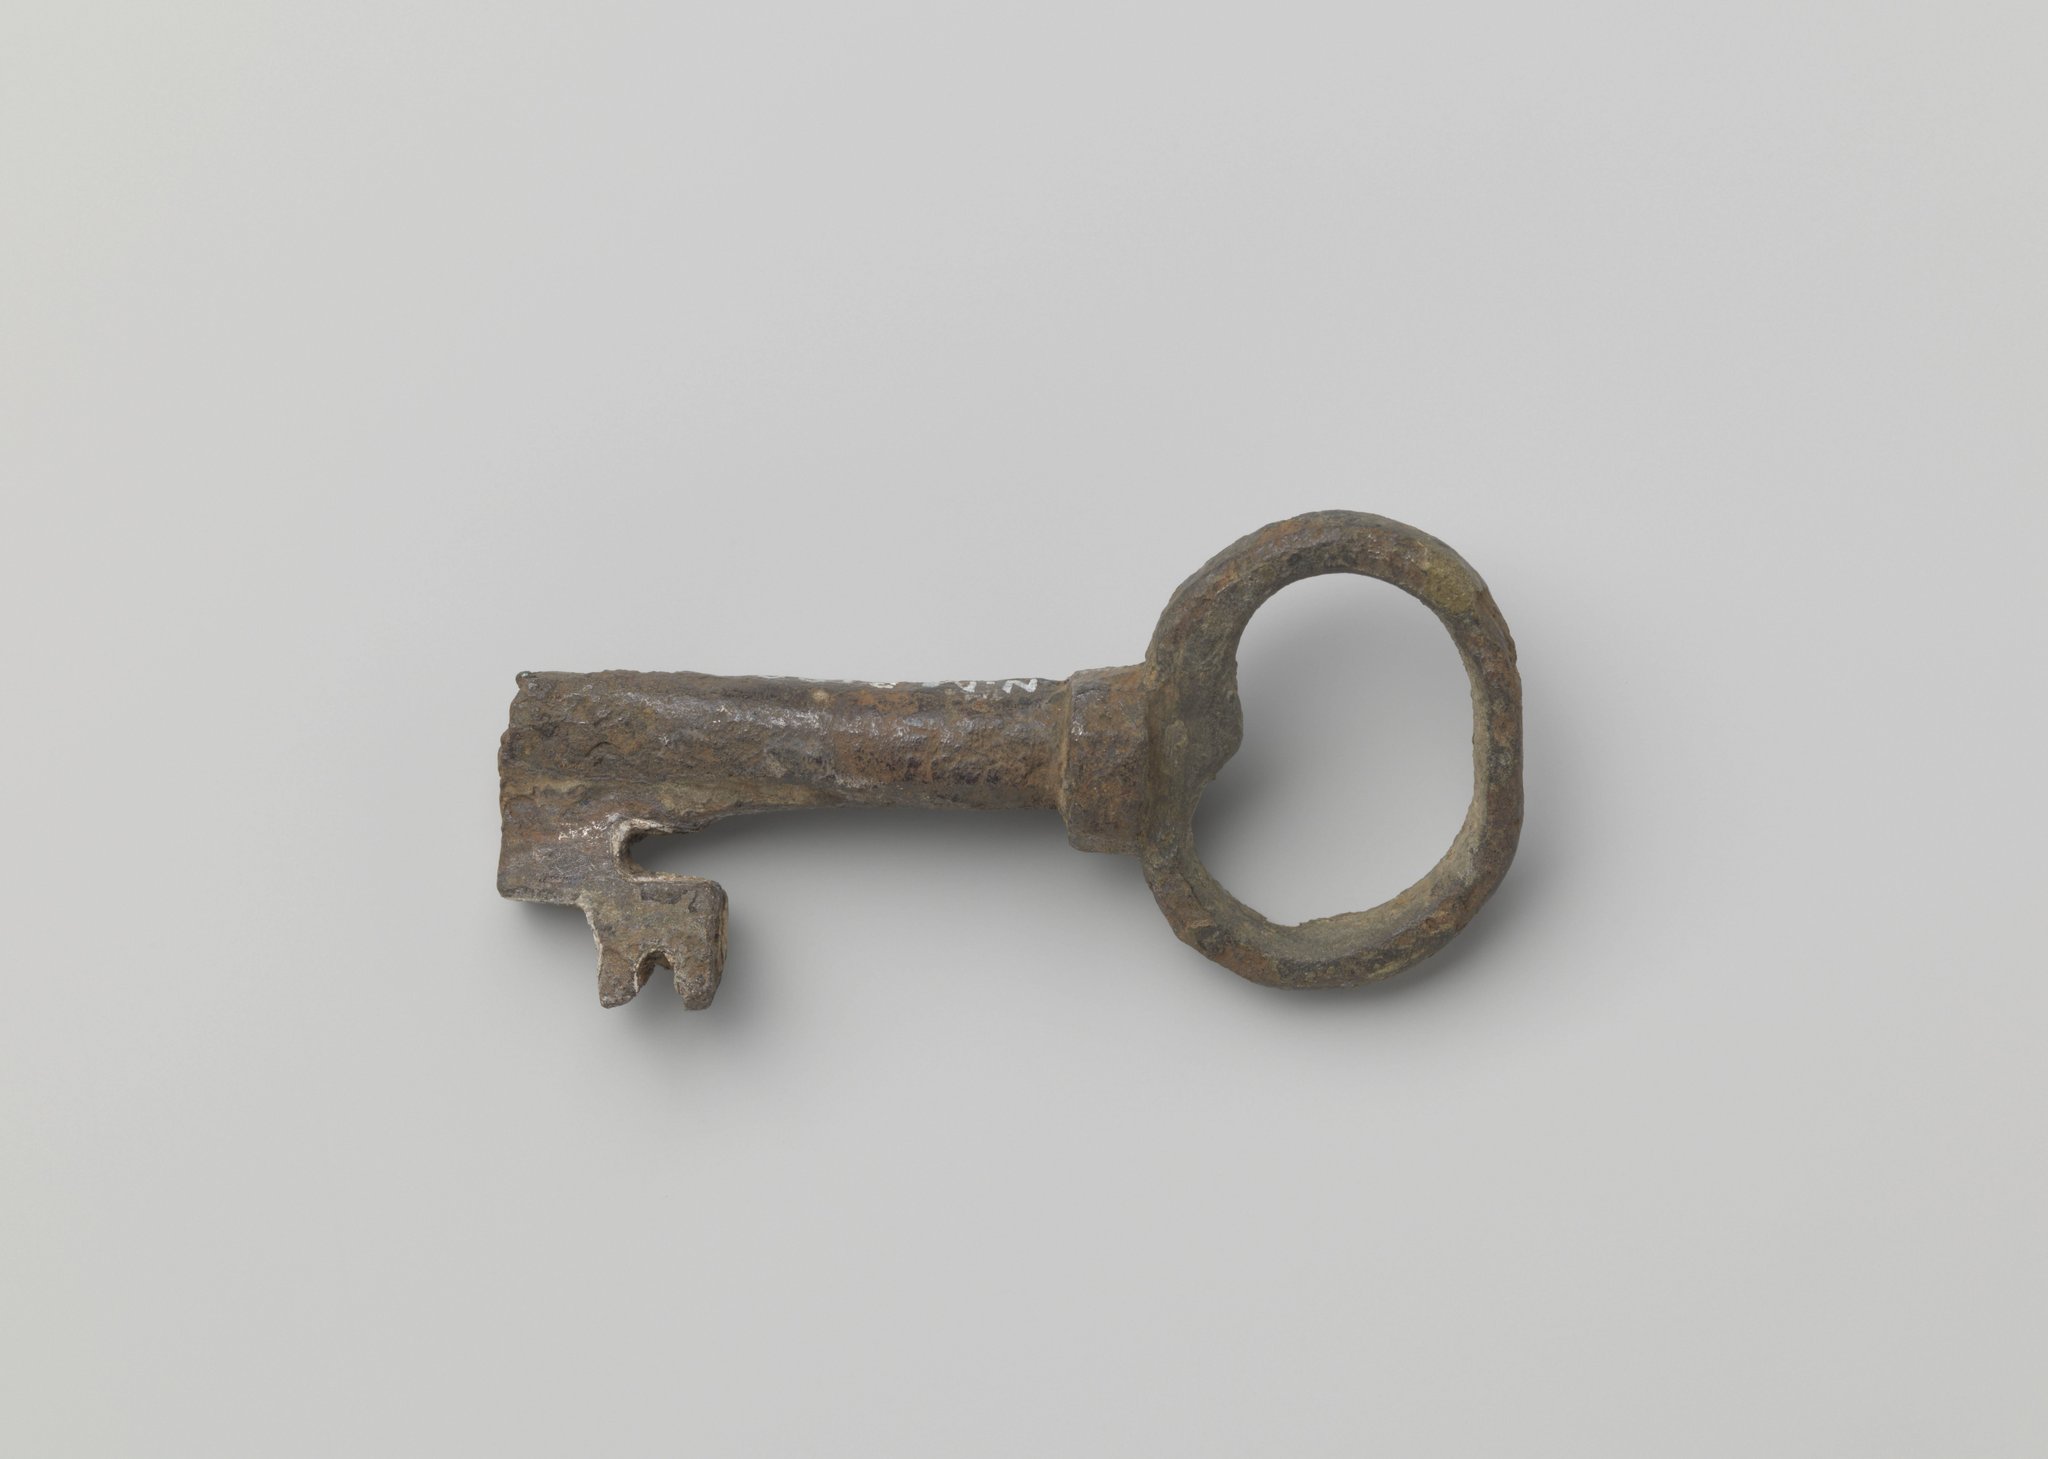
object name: key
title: Sleutel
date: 1400-1950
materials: iron